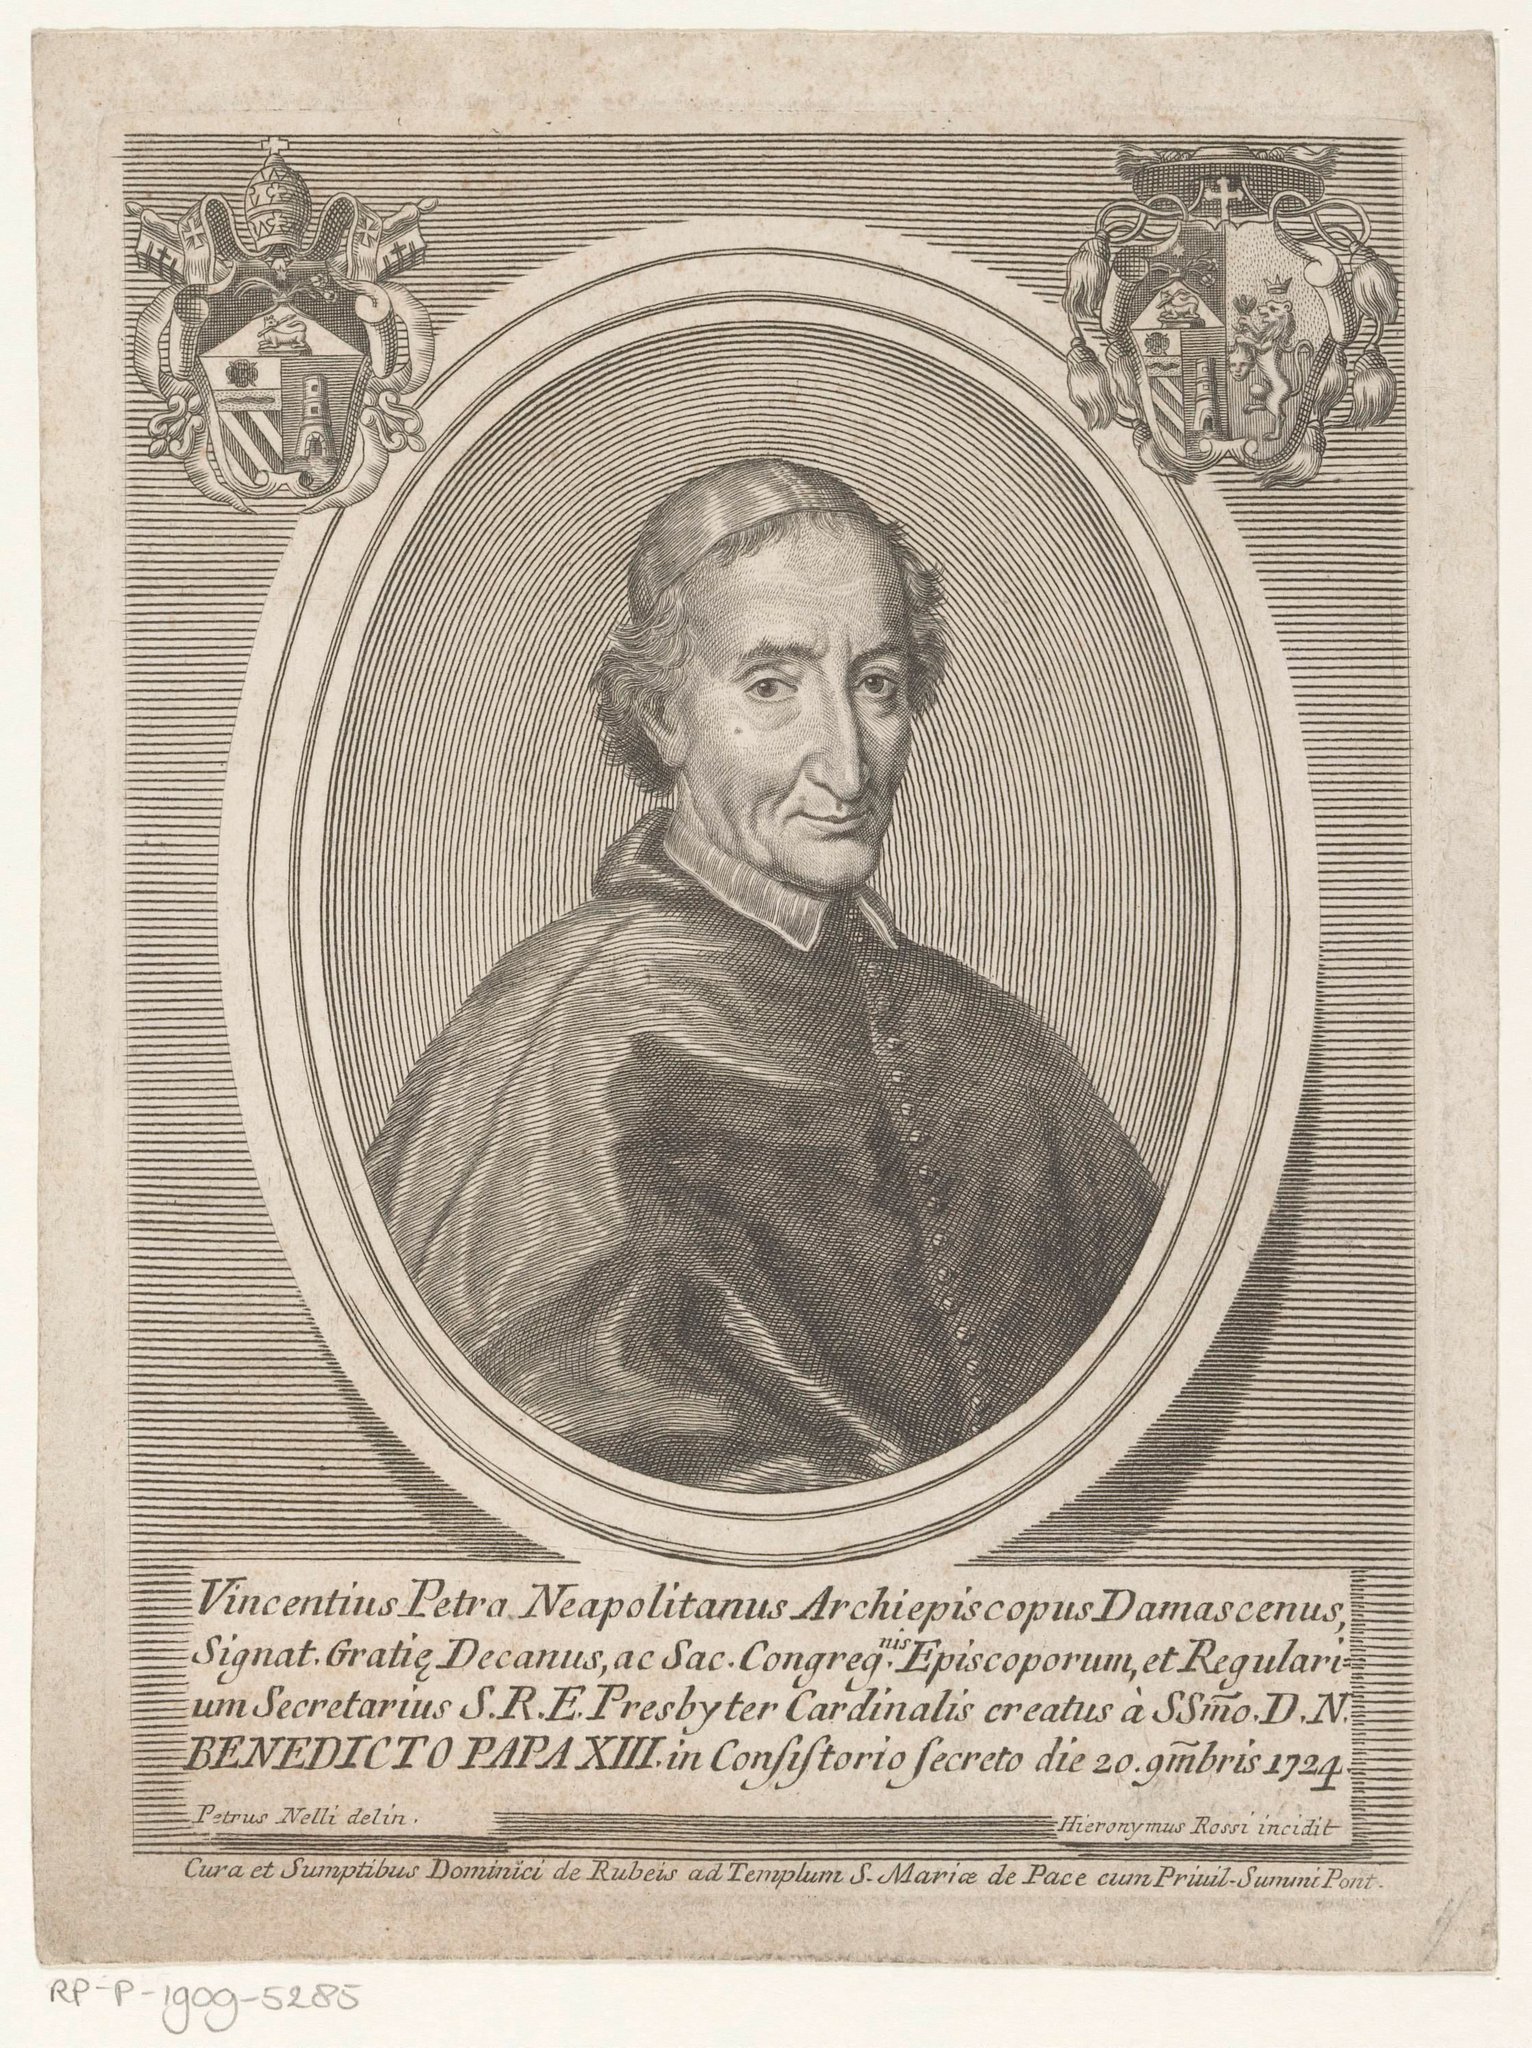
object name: print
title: Portret van kardinaal Vincenzo Petra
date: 1724-1762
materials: paper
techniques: engraving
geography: italy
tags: naples, rome, cardinal, historical persons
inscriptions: collector's mark: Lugt 2228